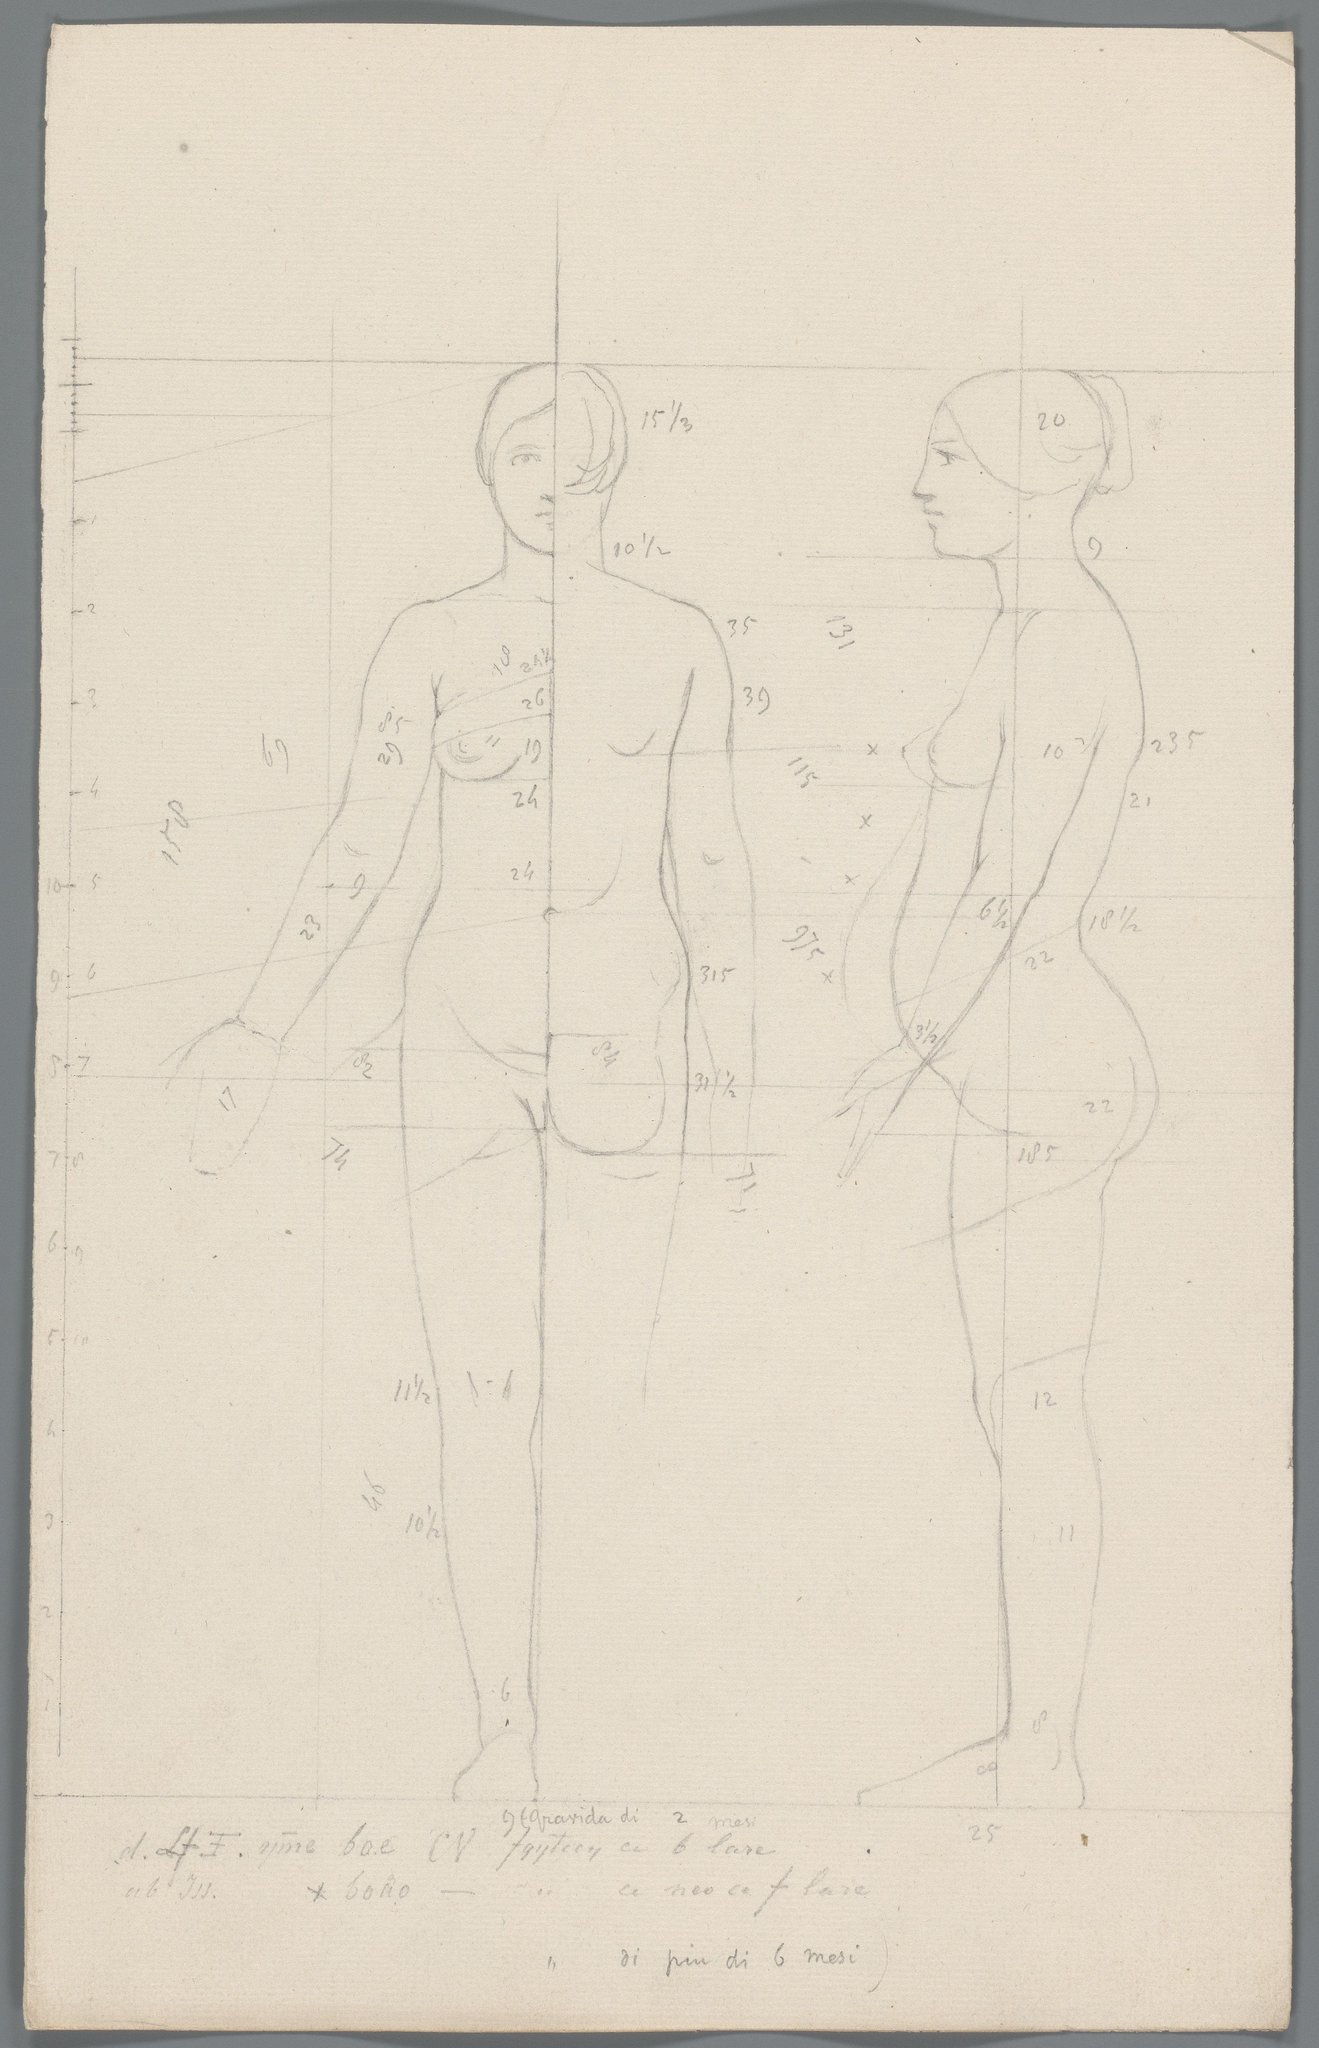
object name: drawing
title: Proportiestudie van een vrouw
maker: jacobus everhardus josephus van den berg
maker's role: draughtsman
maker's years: 1802-1861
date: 1856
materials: paper, pencil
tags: standing figure (canon, proportions) - aa - female human figure, anatomy (non-medical) - aa - female human figure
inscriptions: inscription: ‘D Lf EF (...)’